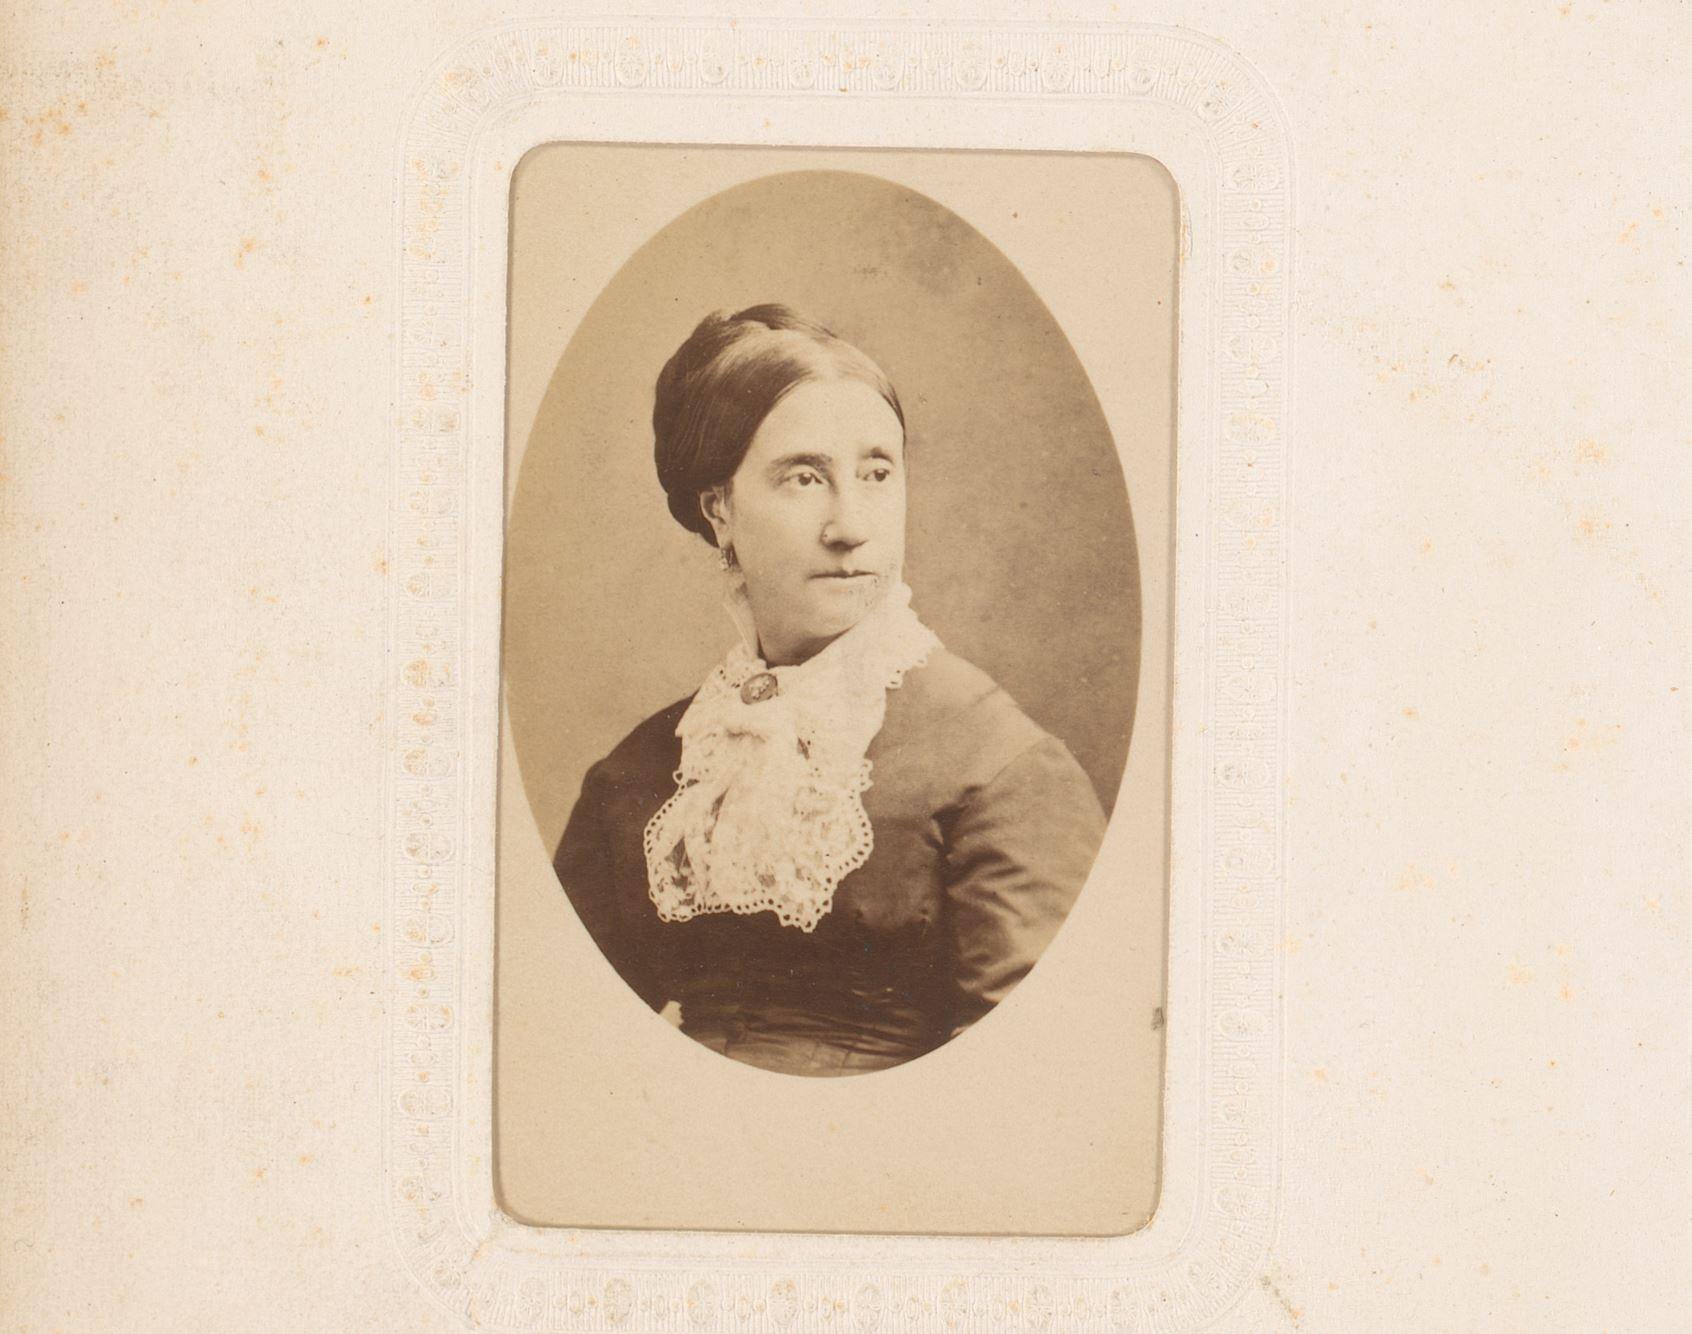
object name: album leaf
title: Portret van een vrouw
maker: Anonymous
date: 1860-1900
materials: cardboard, photographic support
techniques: albumen print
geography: netherlands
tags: historical persons - bb - woman